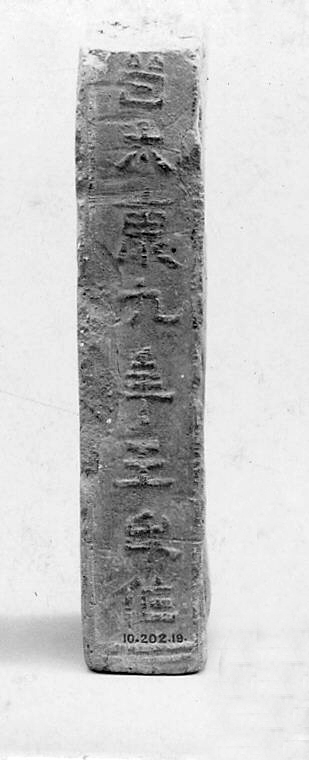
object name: tile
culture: chinese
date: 221 BCE-220 CE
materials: earthenware